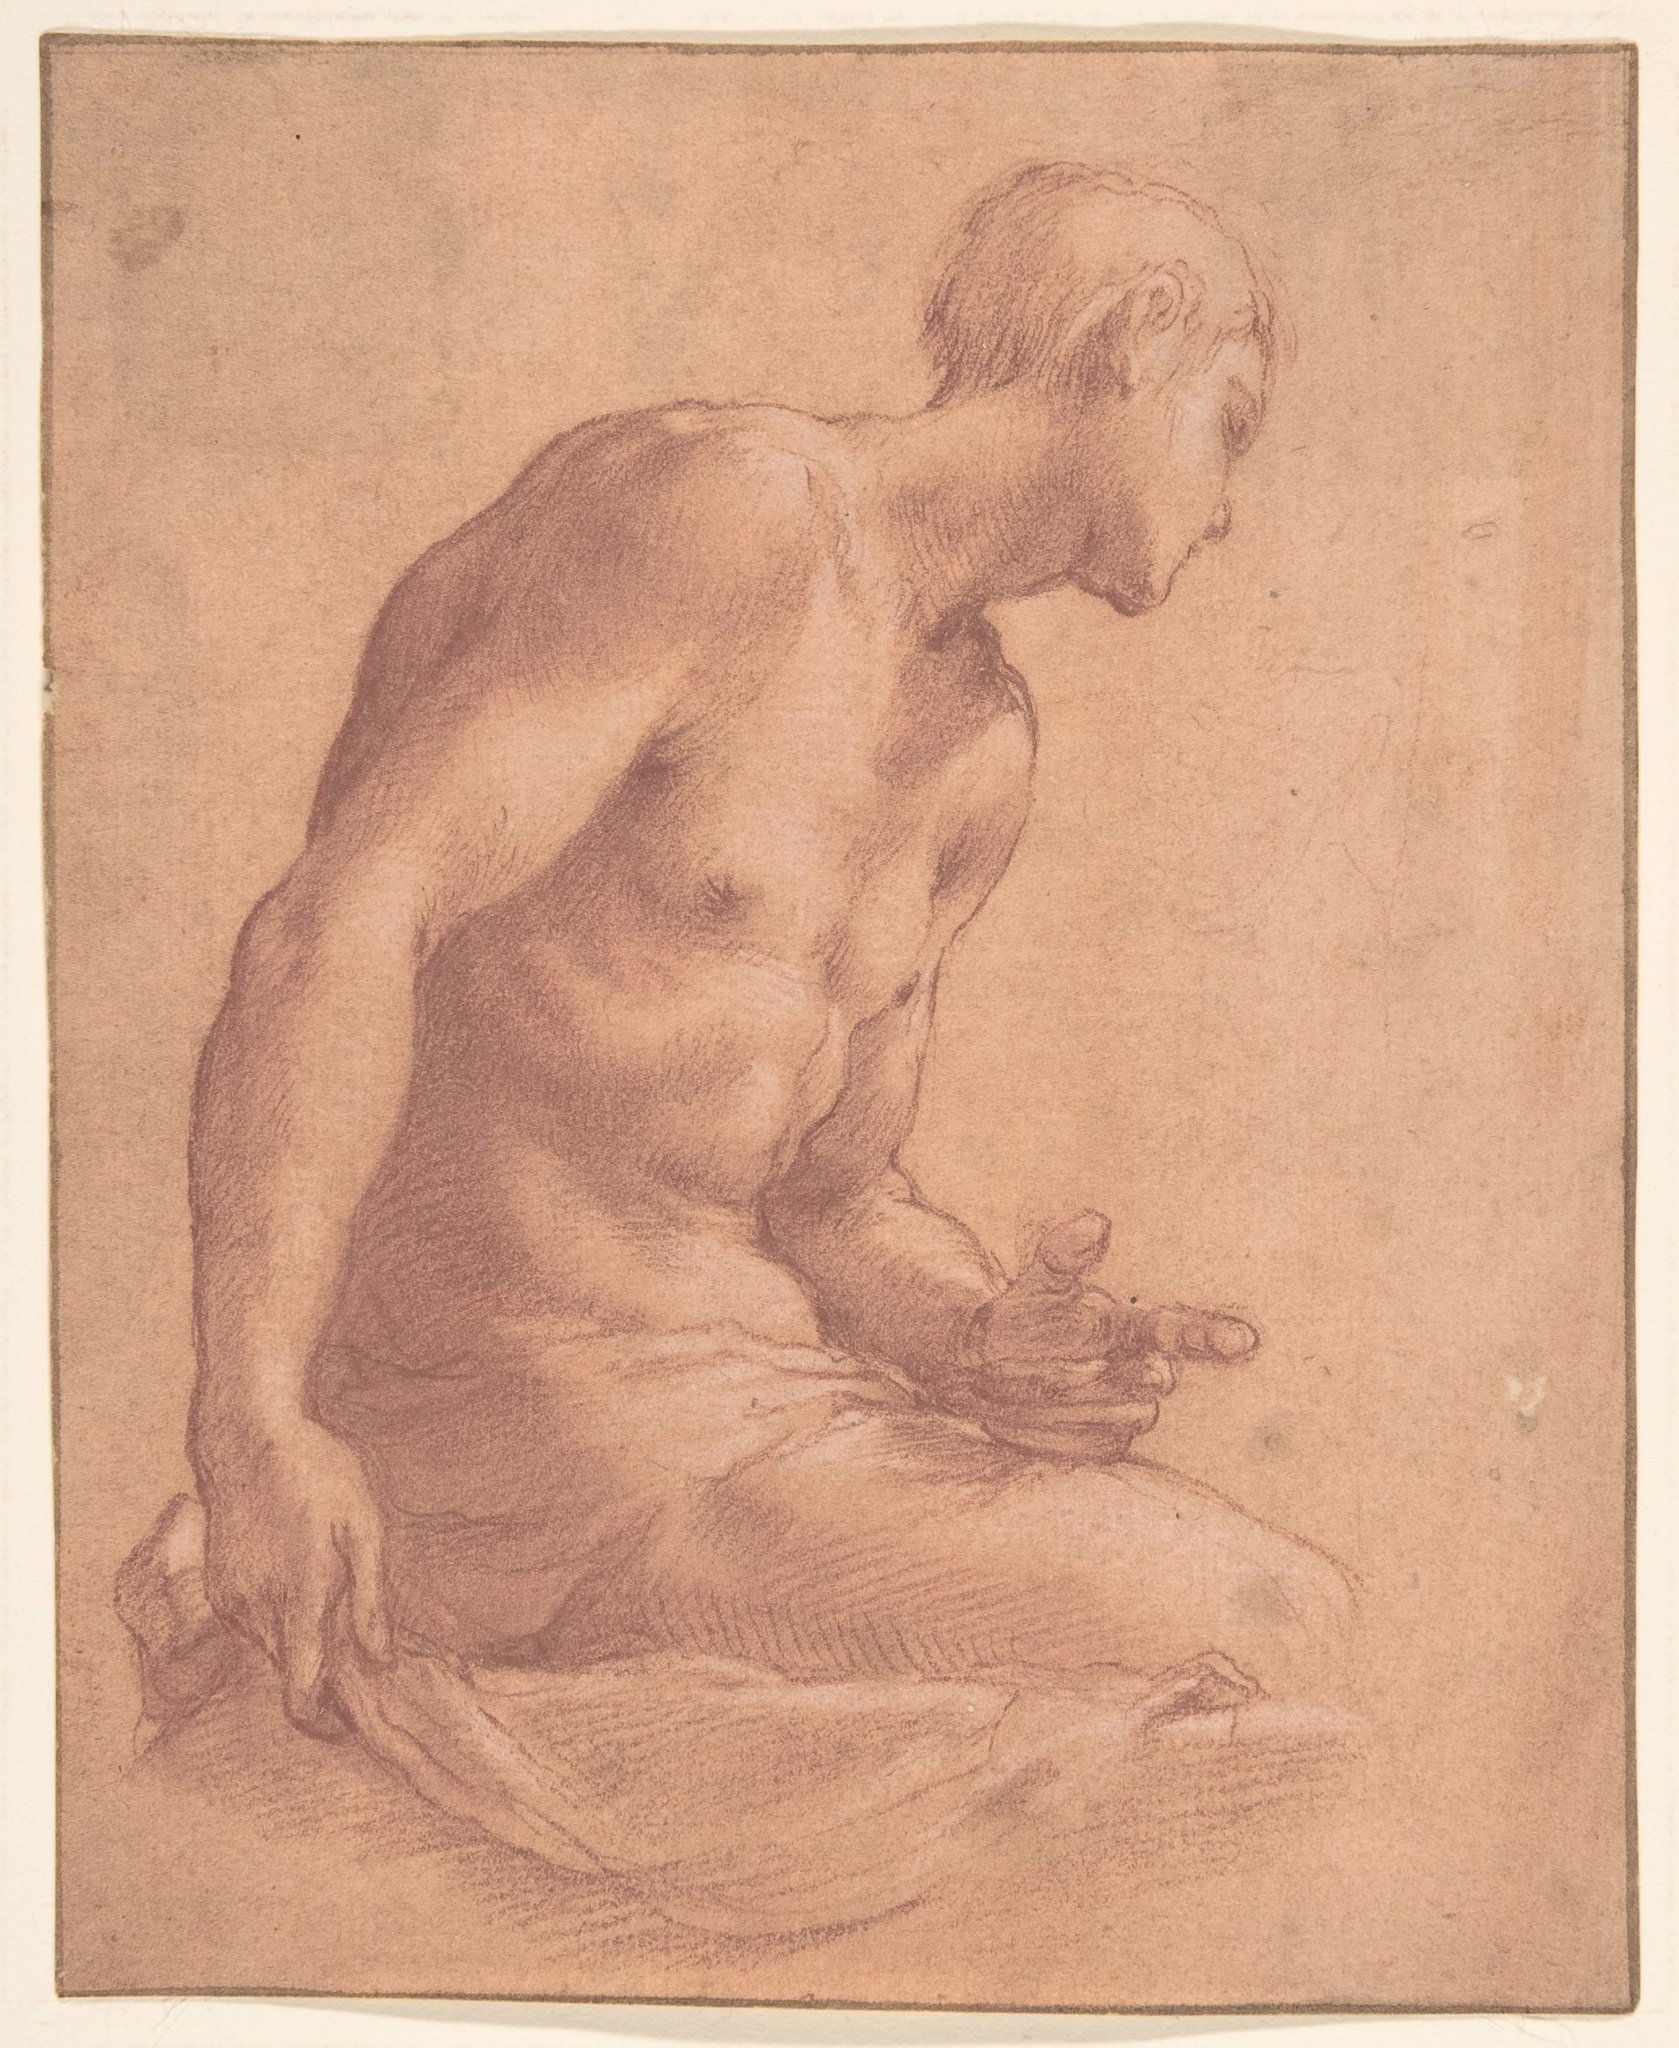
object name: drawing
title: Seated Boy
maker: girolamo macchietti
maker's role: artist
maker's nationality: italian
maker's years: 1535-1592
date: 1535-1592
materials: chalk, ink, paper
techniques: highlighting, pen, wash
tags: boys